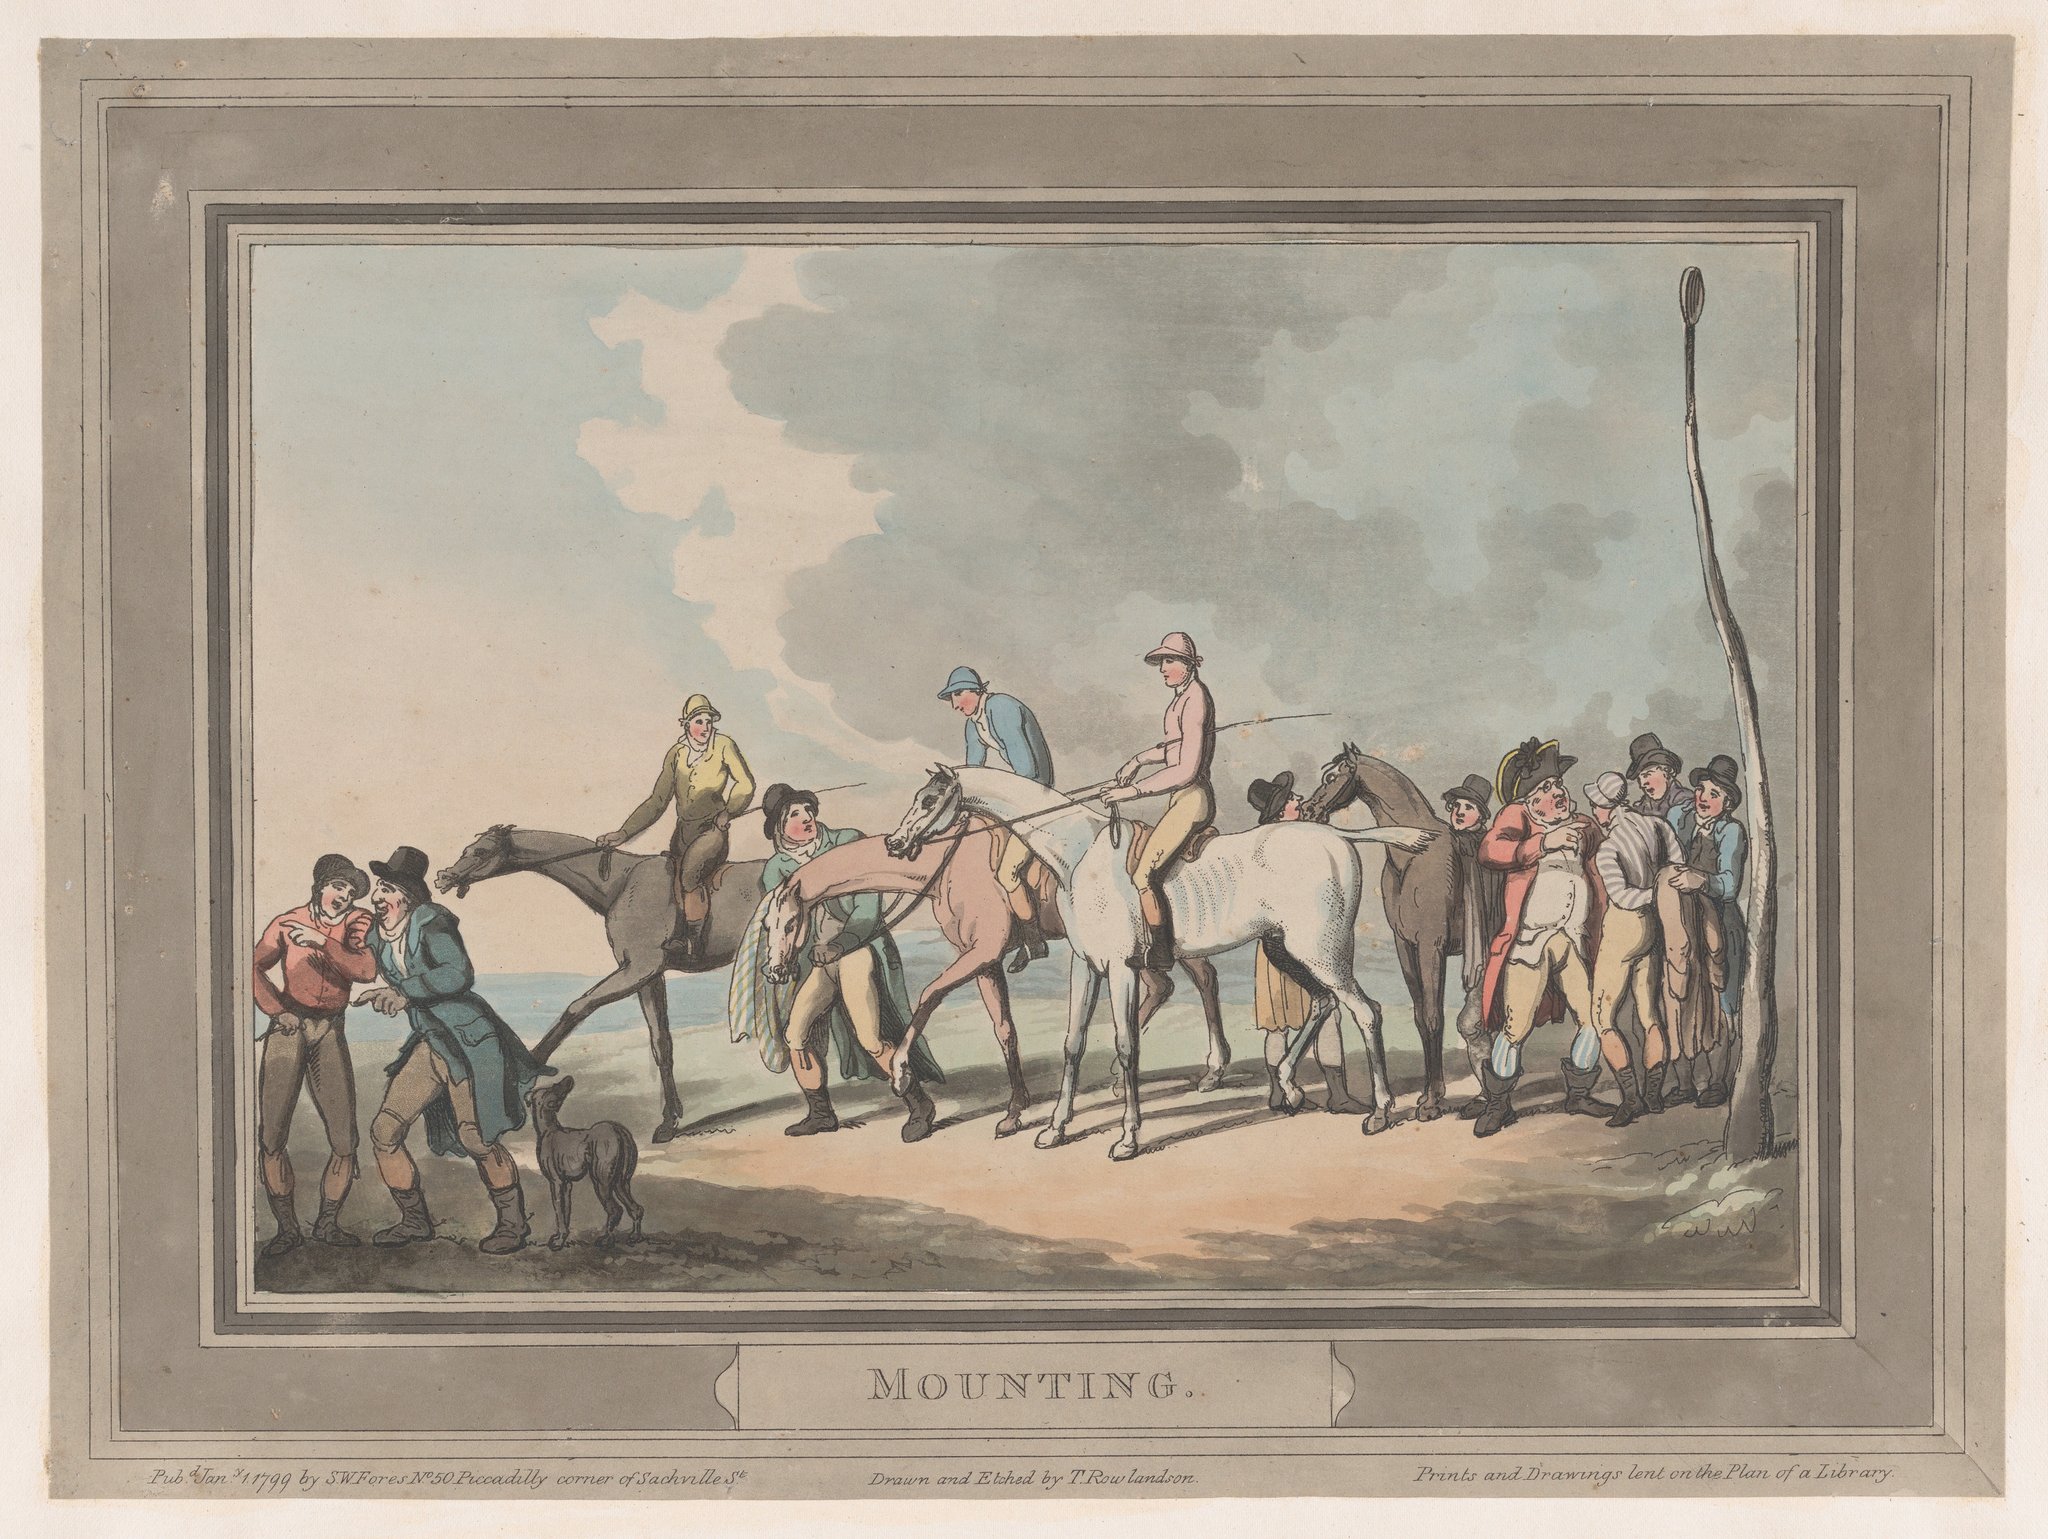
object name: print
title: Mounting [The Mount]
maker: thomas rowlandson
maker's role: artist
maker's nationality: british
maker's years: 1757-1827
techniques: aquatint, etching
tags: men,horses